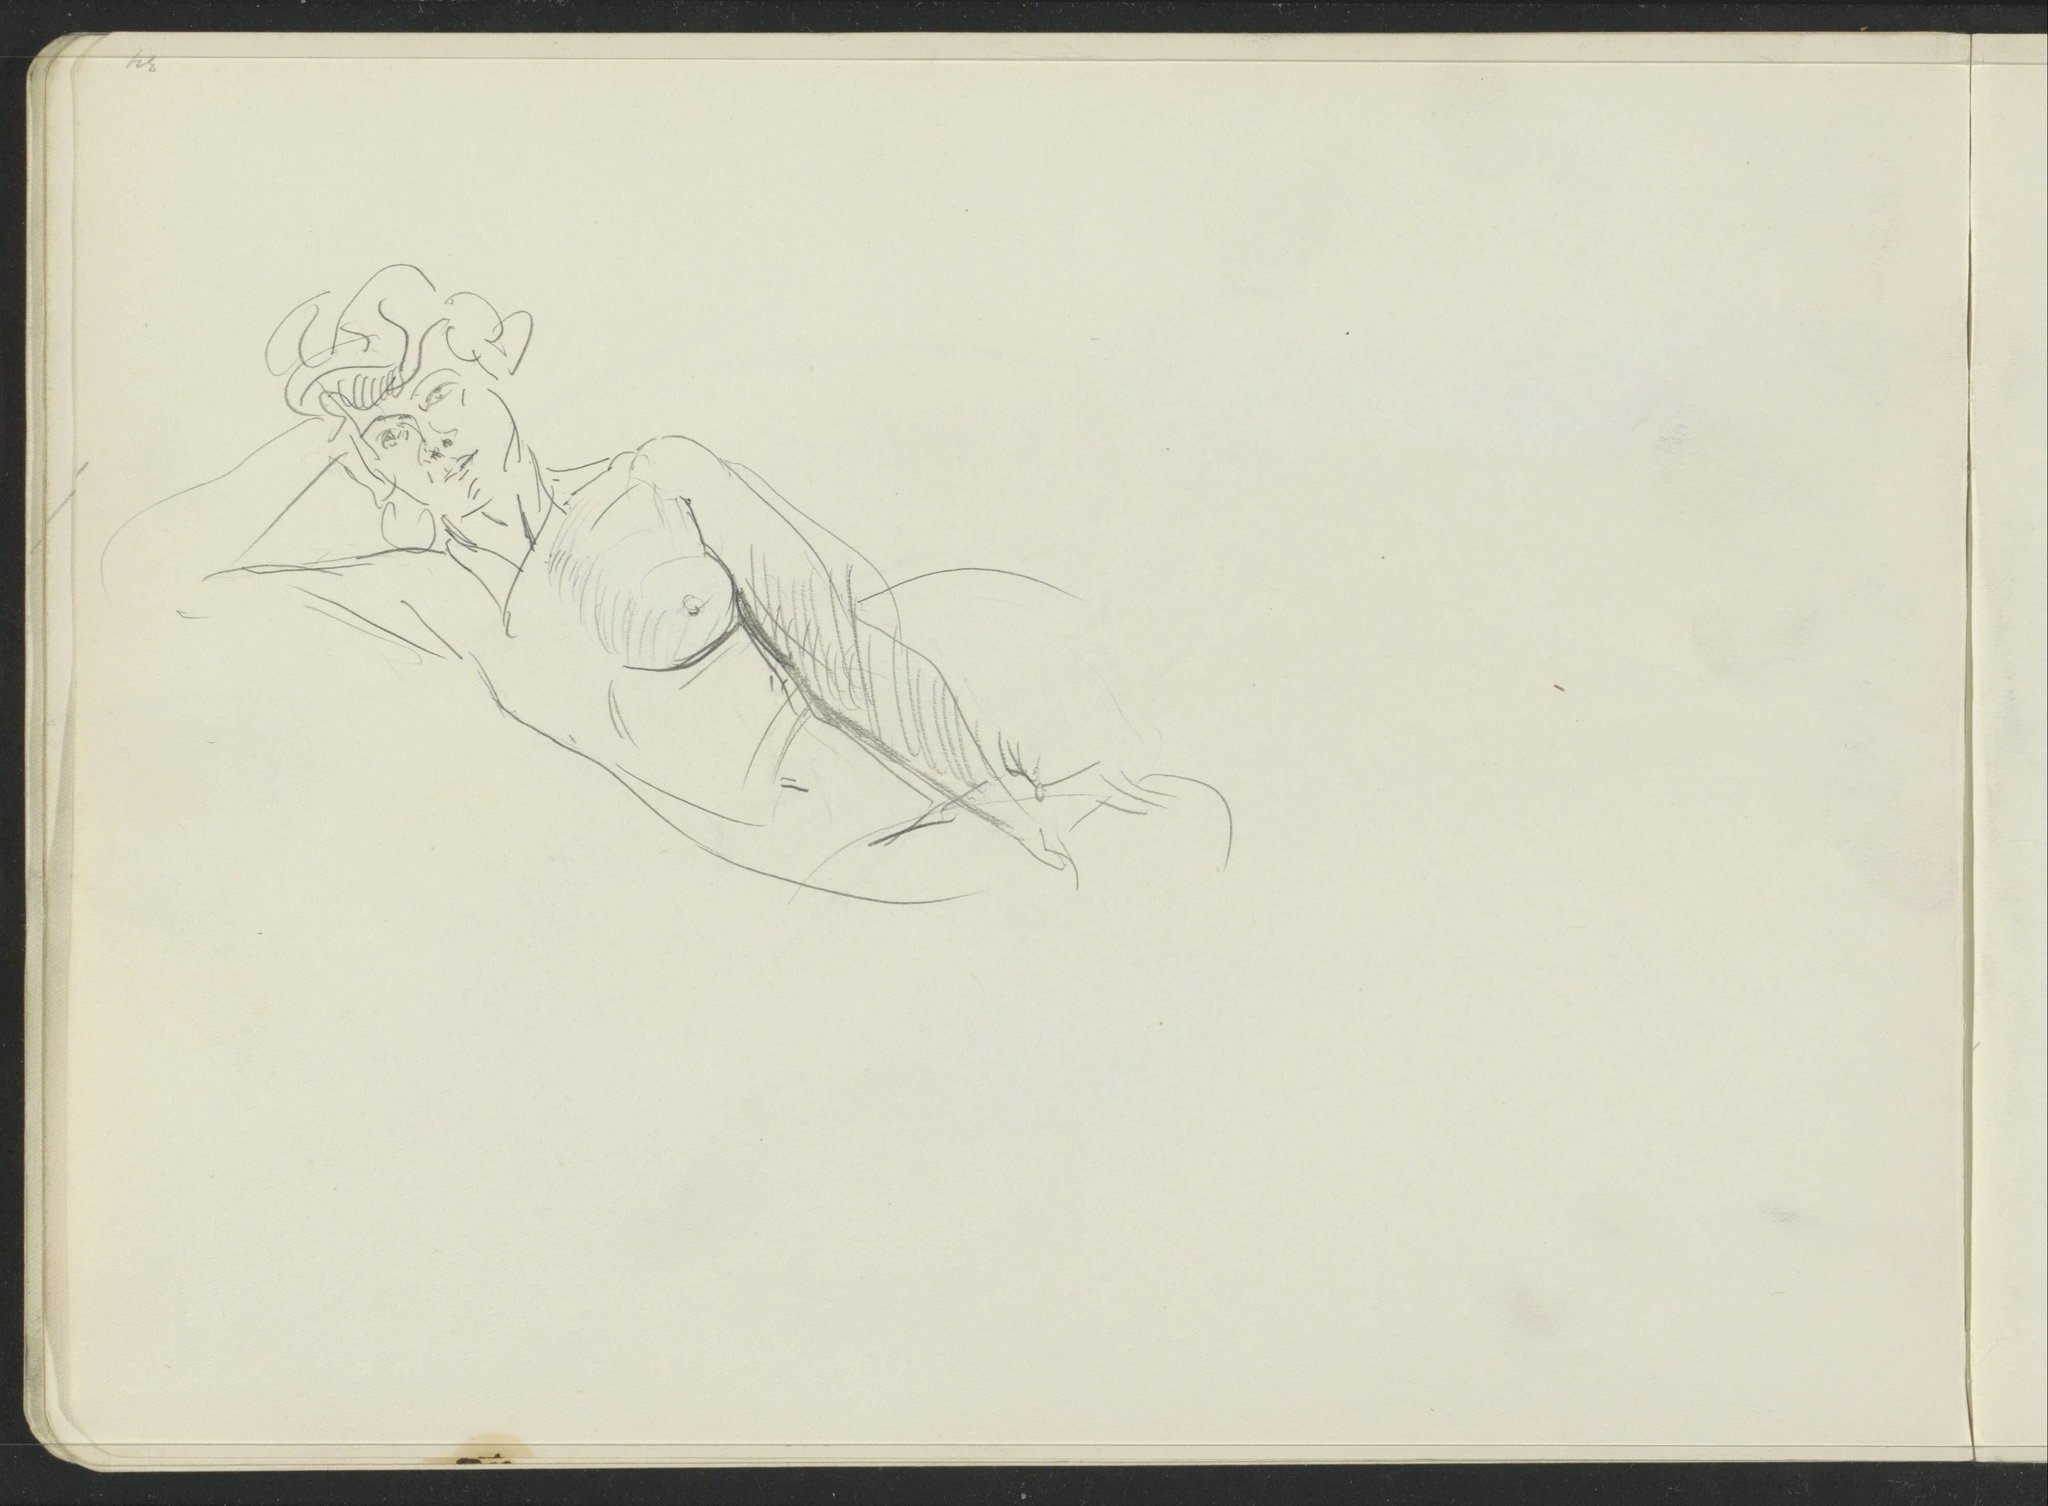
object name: sketchbook leaf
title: Zittend vrouwelijk naakt, leunend op een arm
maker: isaac israels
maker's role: draughtsman, painter, print maker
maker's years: 1865-1934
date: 1915-1934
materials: paper, pencil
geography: the hague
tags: sitting figure - aa - female human figure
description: Blad 11 verso uit schetsboek XV met 22 bladen.